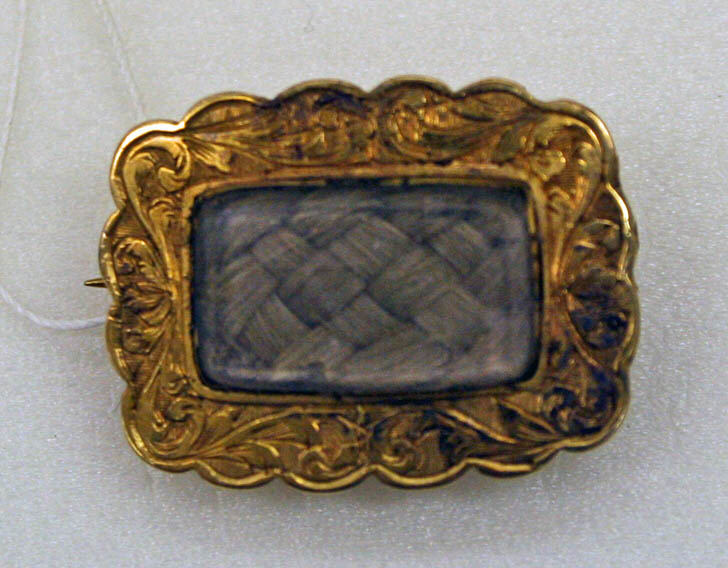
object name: mourning jewelry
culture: american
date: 1834-1866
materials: glass, gold, hair